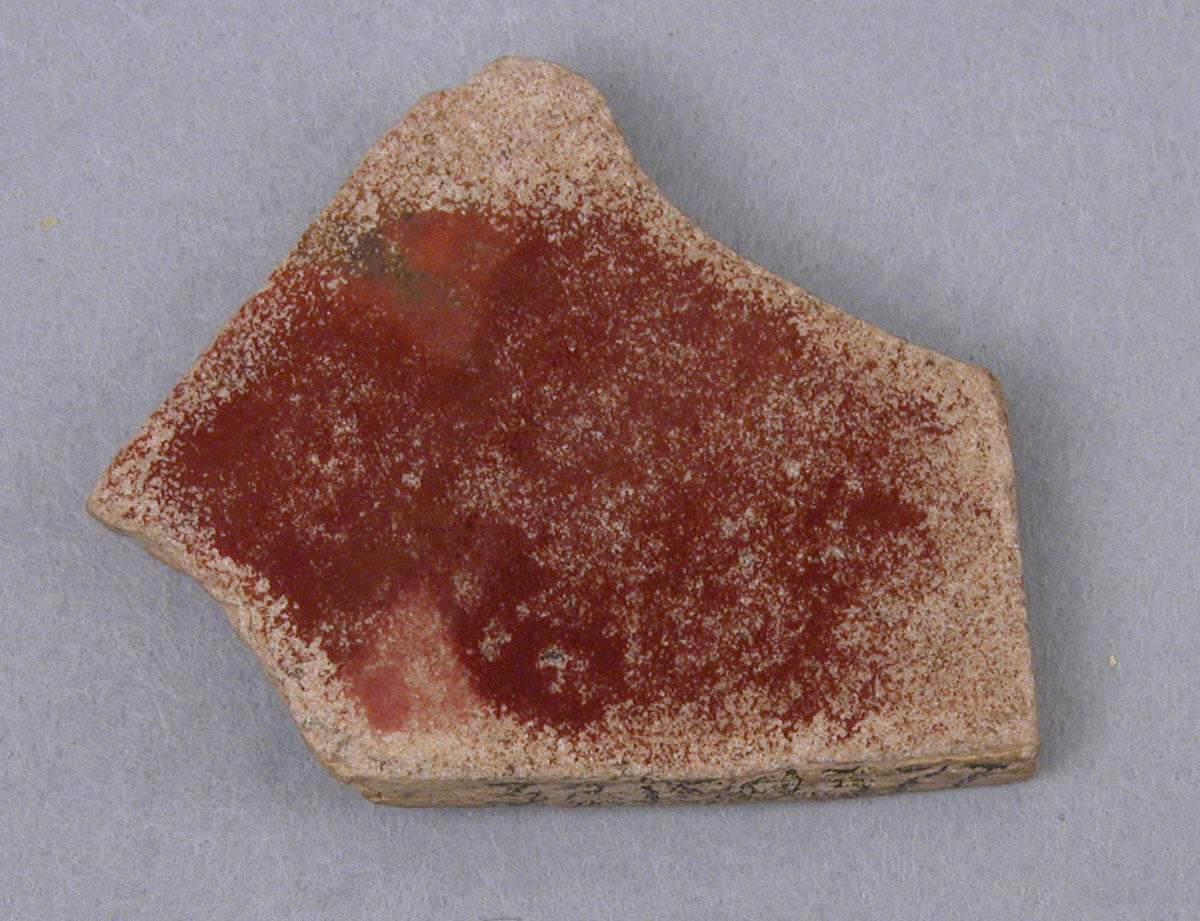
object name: fragment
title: Ceramic Fragment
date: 701-900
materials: earthenware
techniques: glazing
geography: iraq